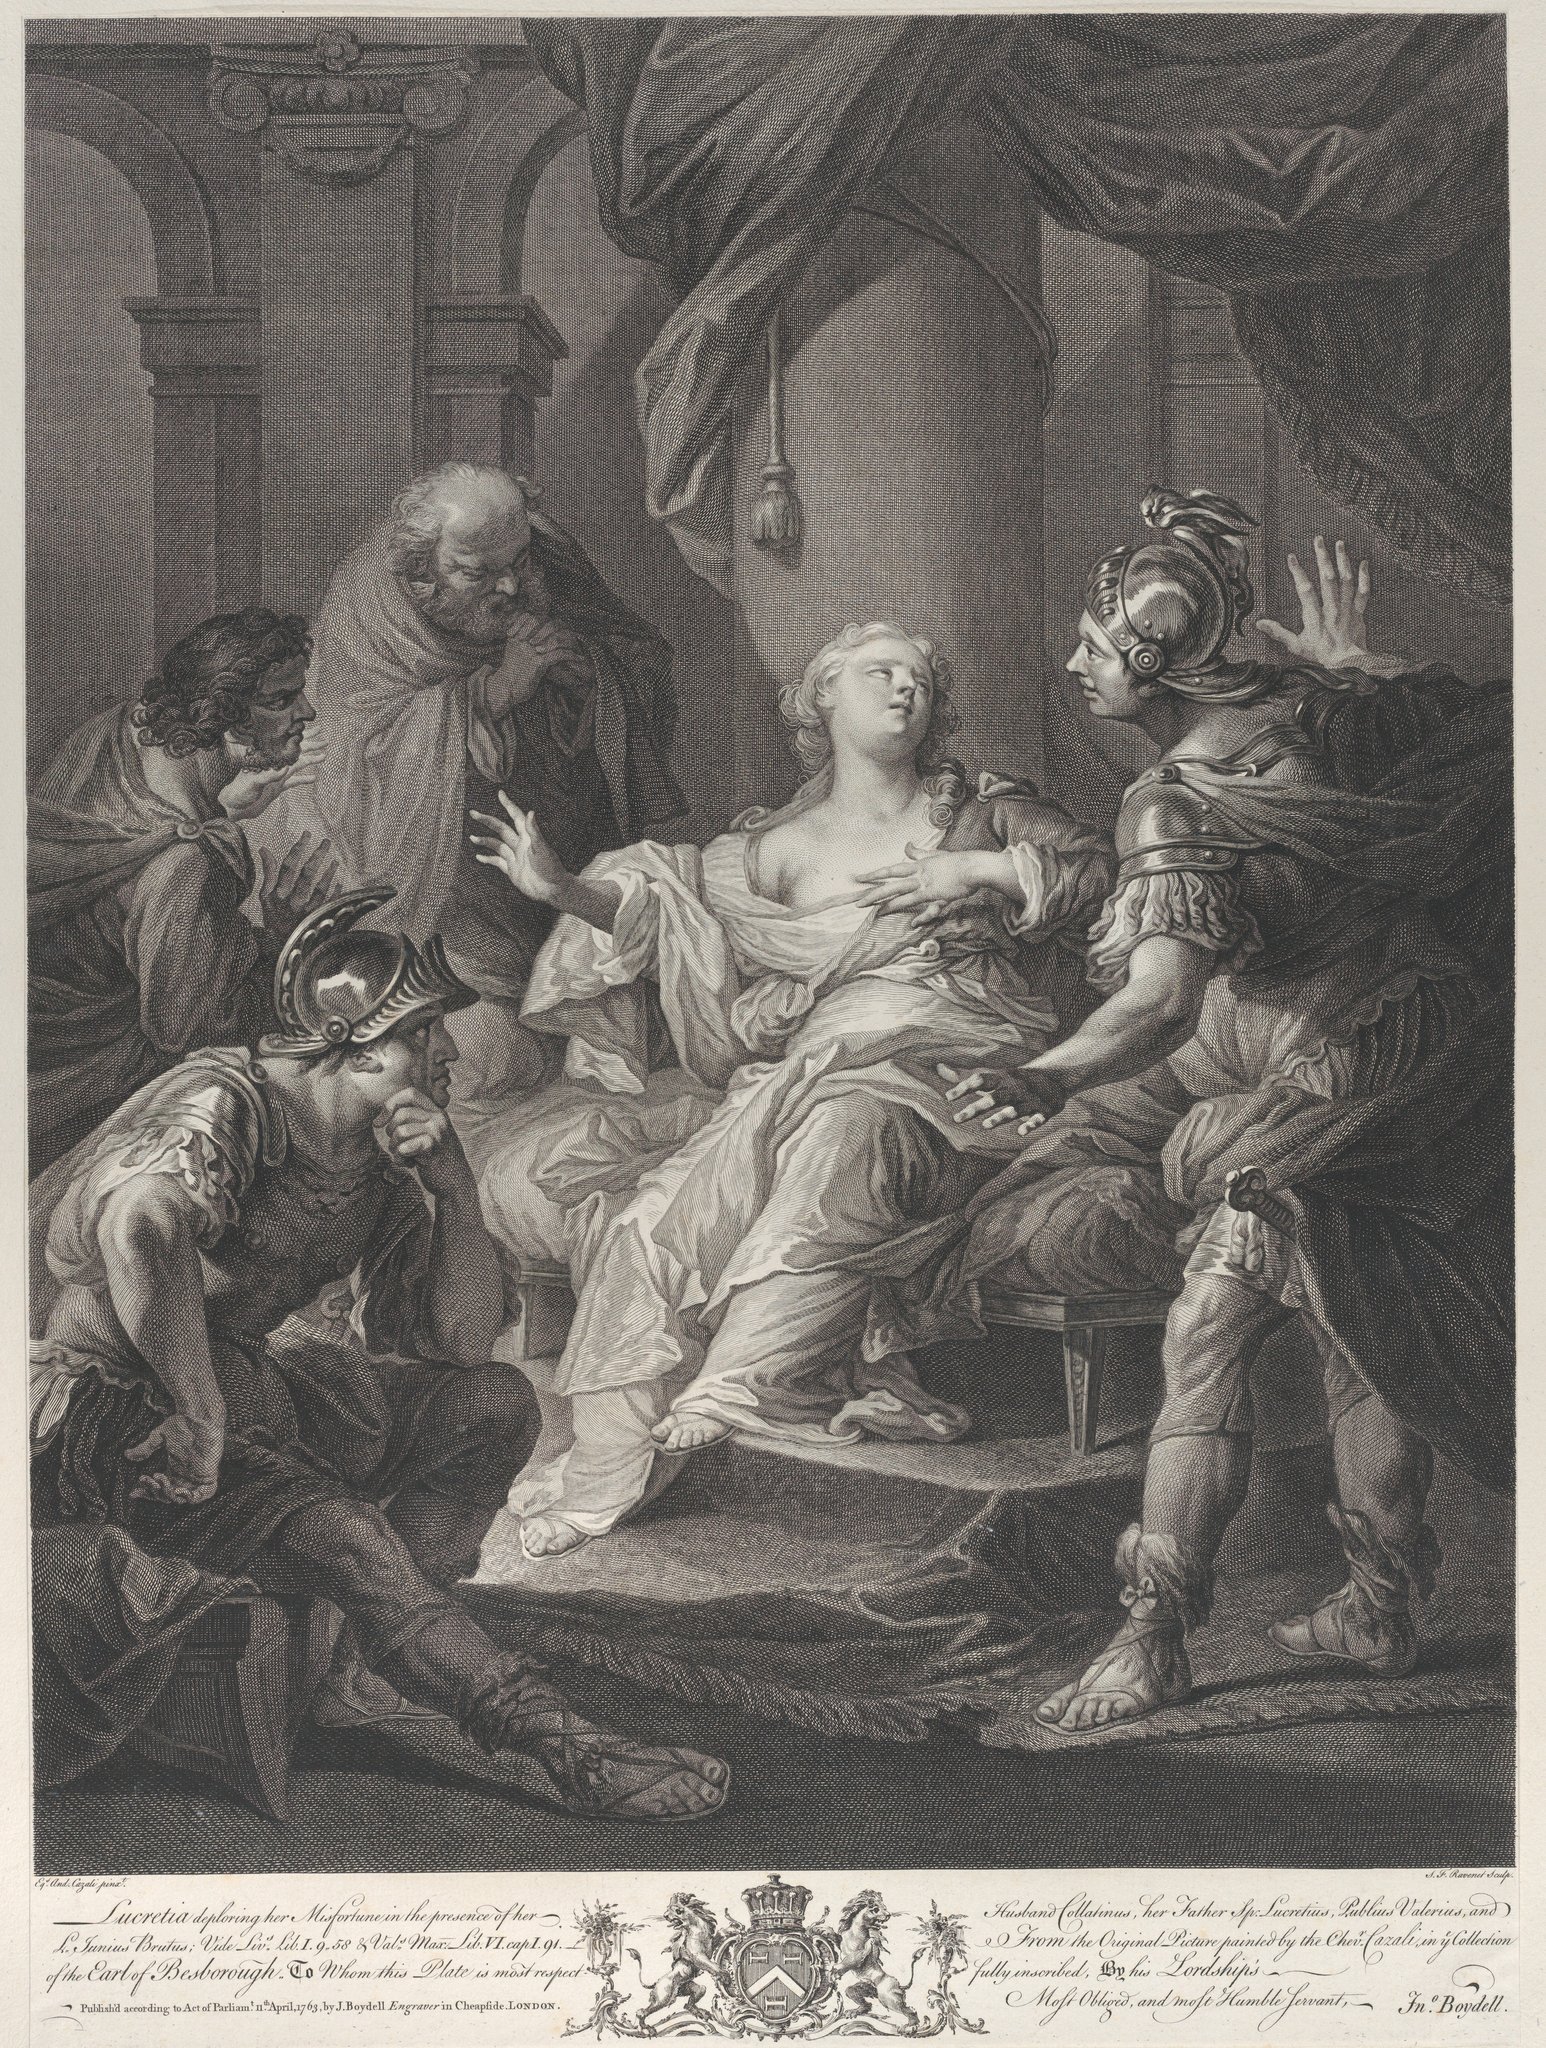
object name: print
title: Lucretia deploring her misfortune to her husband Collatinus, her father, Publius Valerius, and Junius Brutus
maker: simon francis ravenet, the elder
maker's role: artist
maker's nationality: french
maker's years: 1706-1774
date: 1763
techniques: engraving